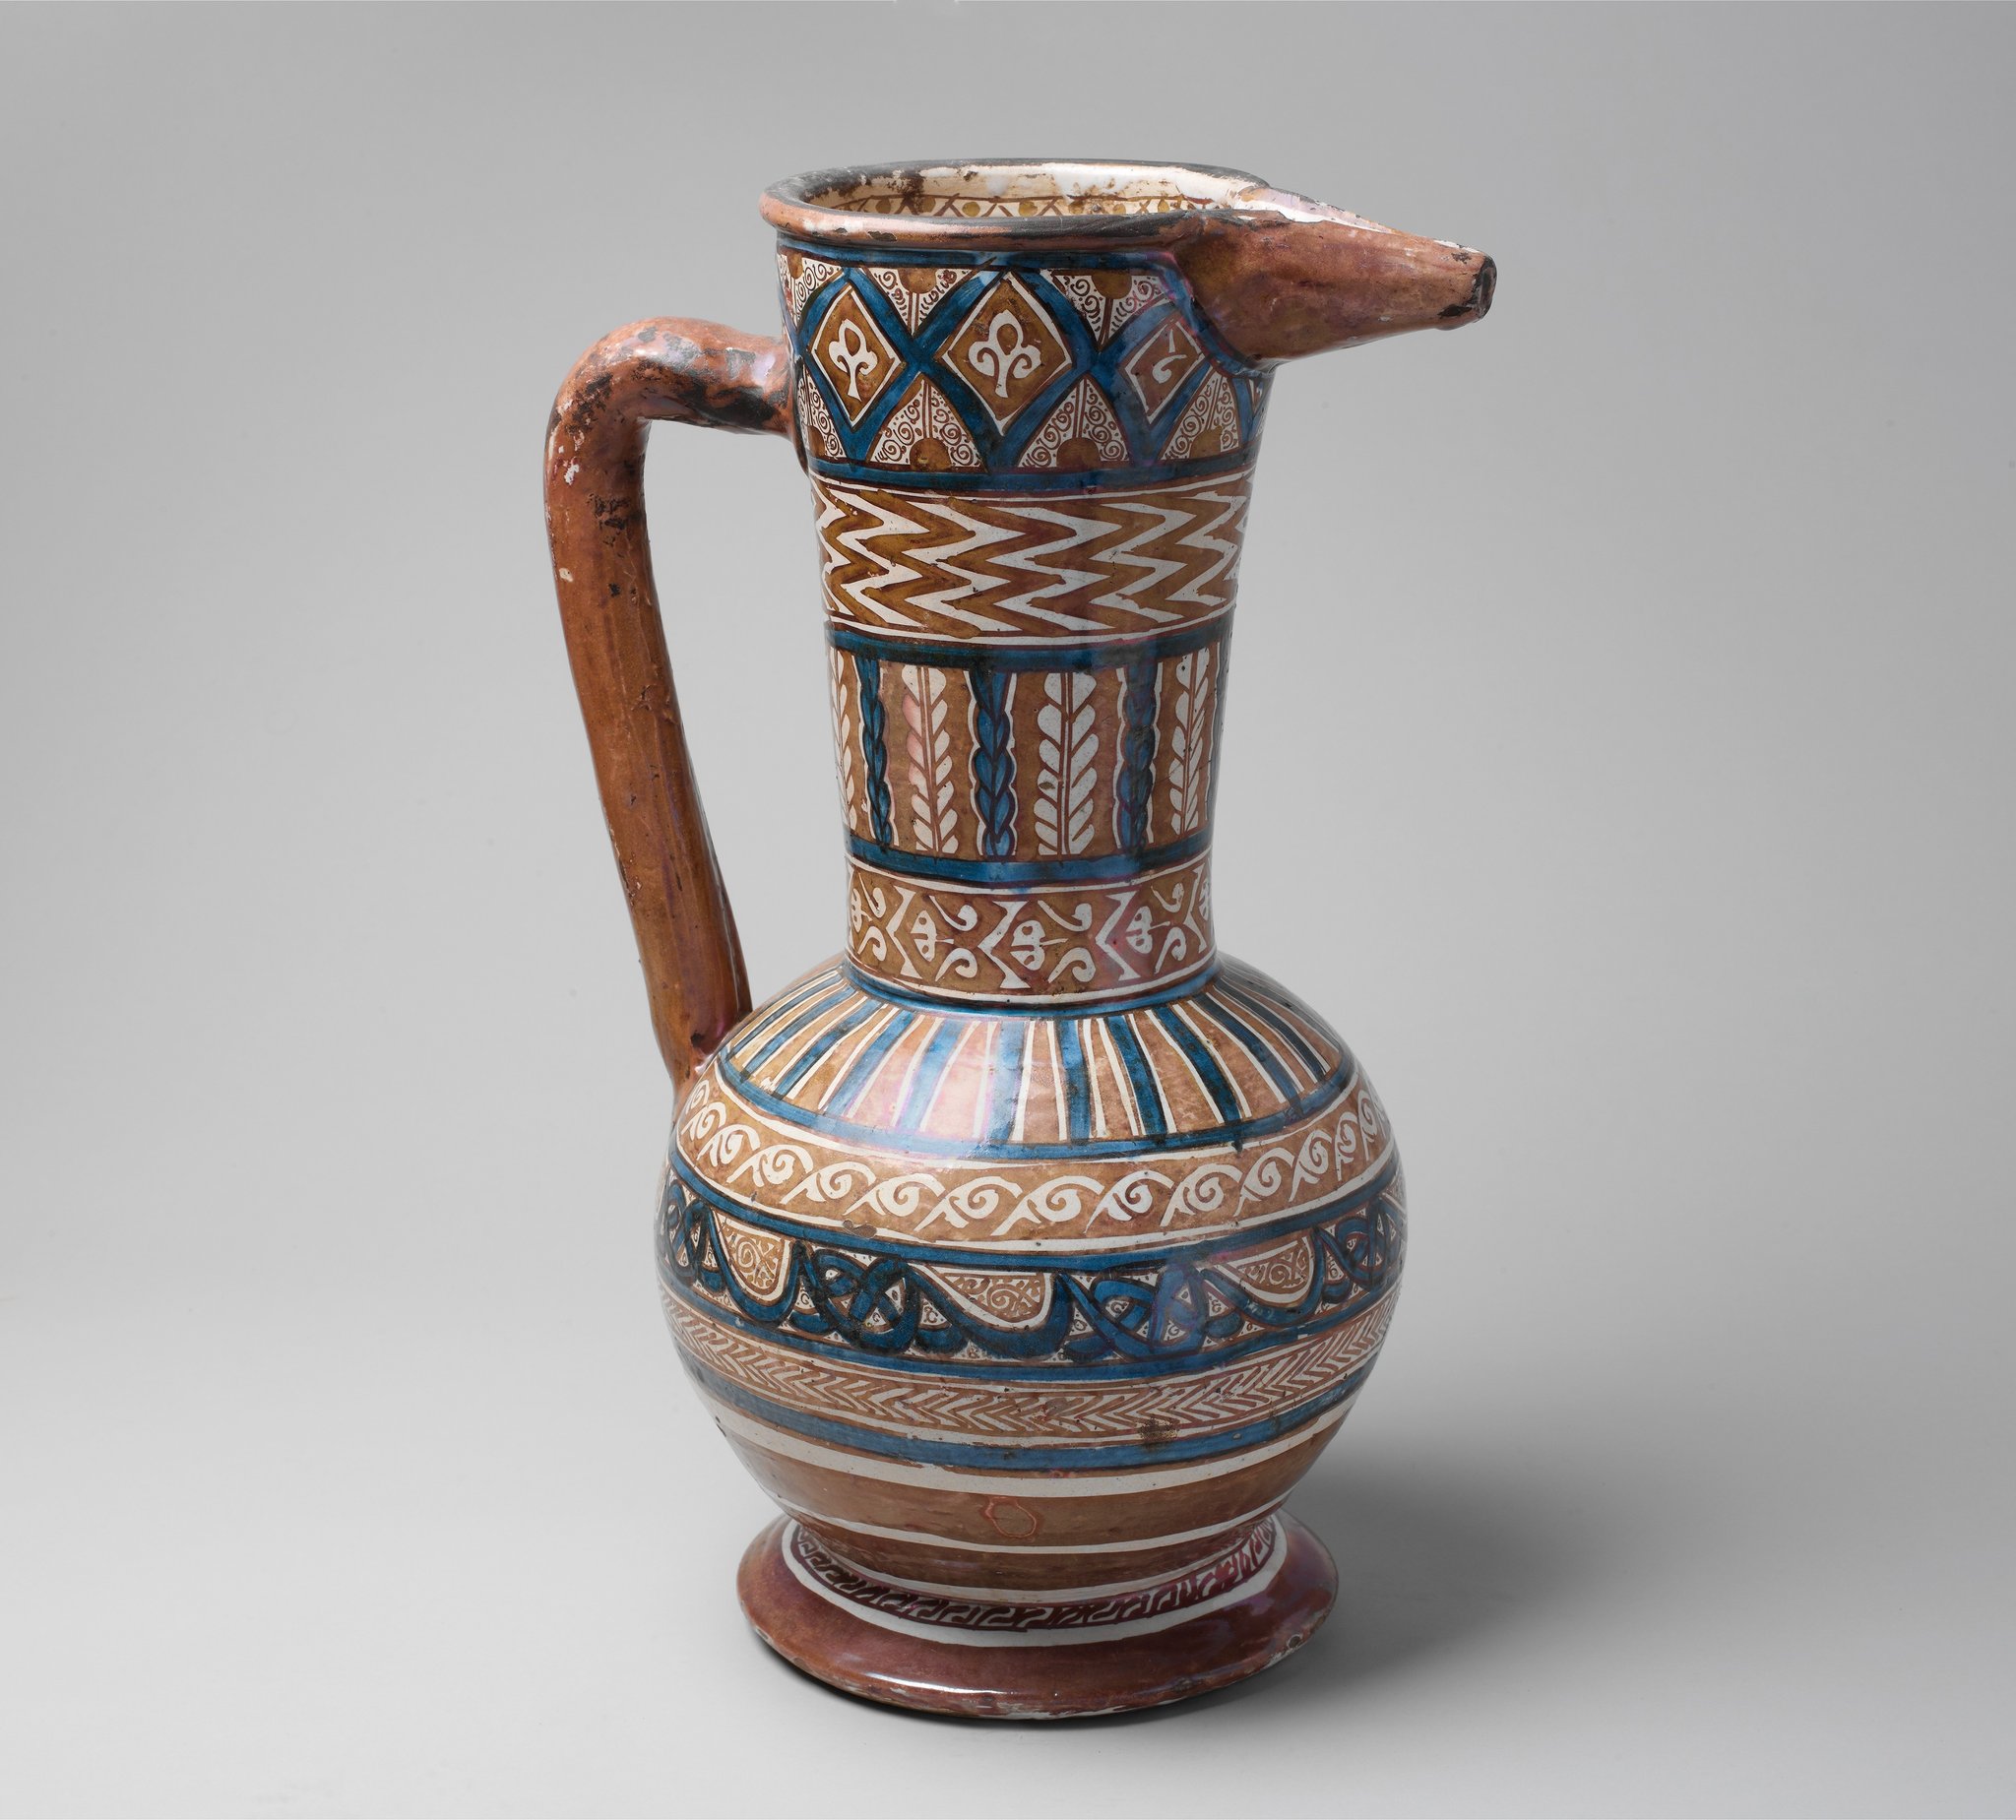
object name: pitcher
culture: spanish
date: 1430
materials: earthenware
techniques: glazing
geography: spain